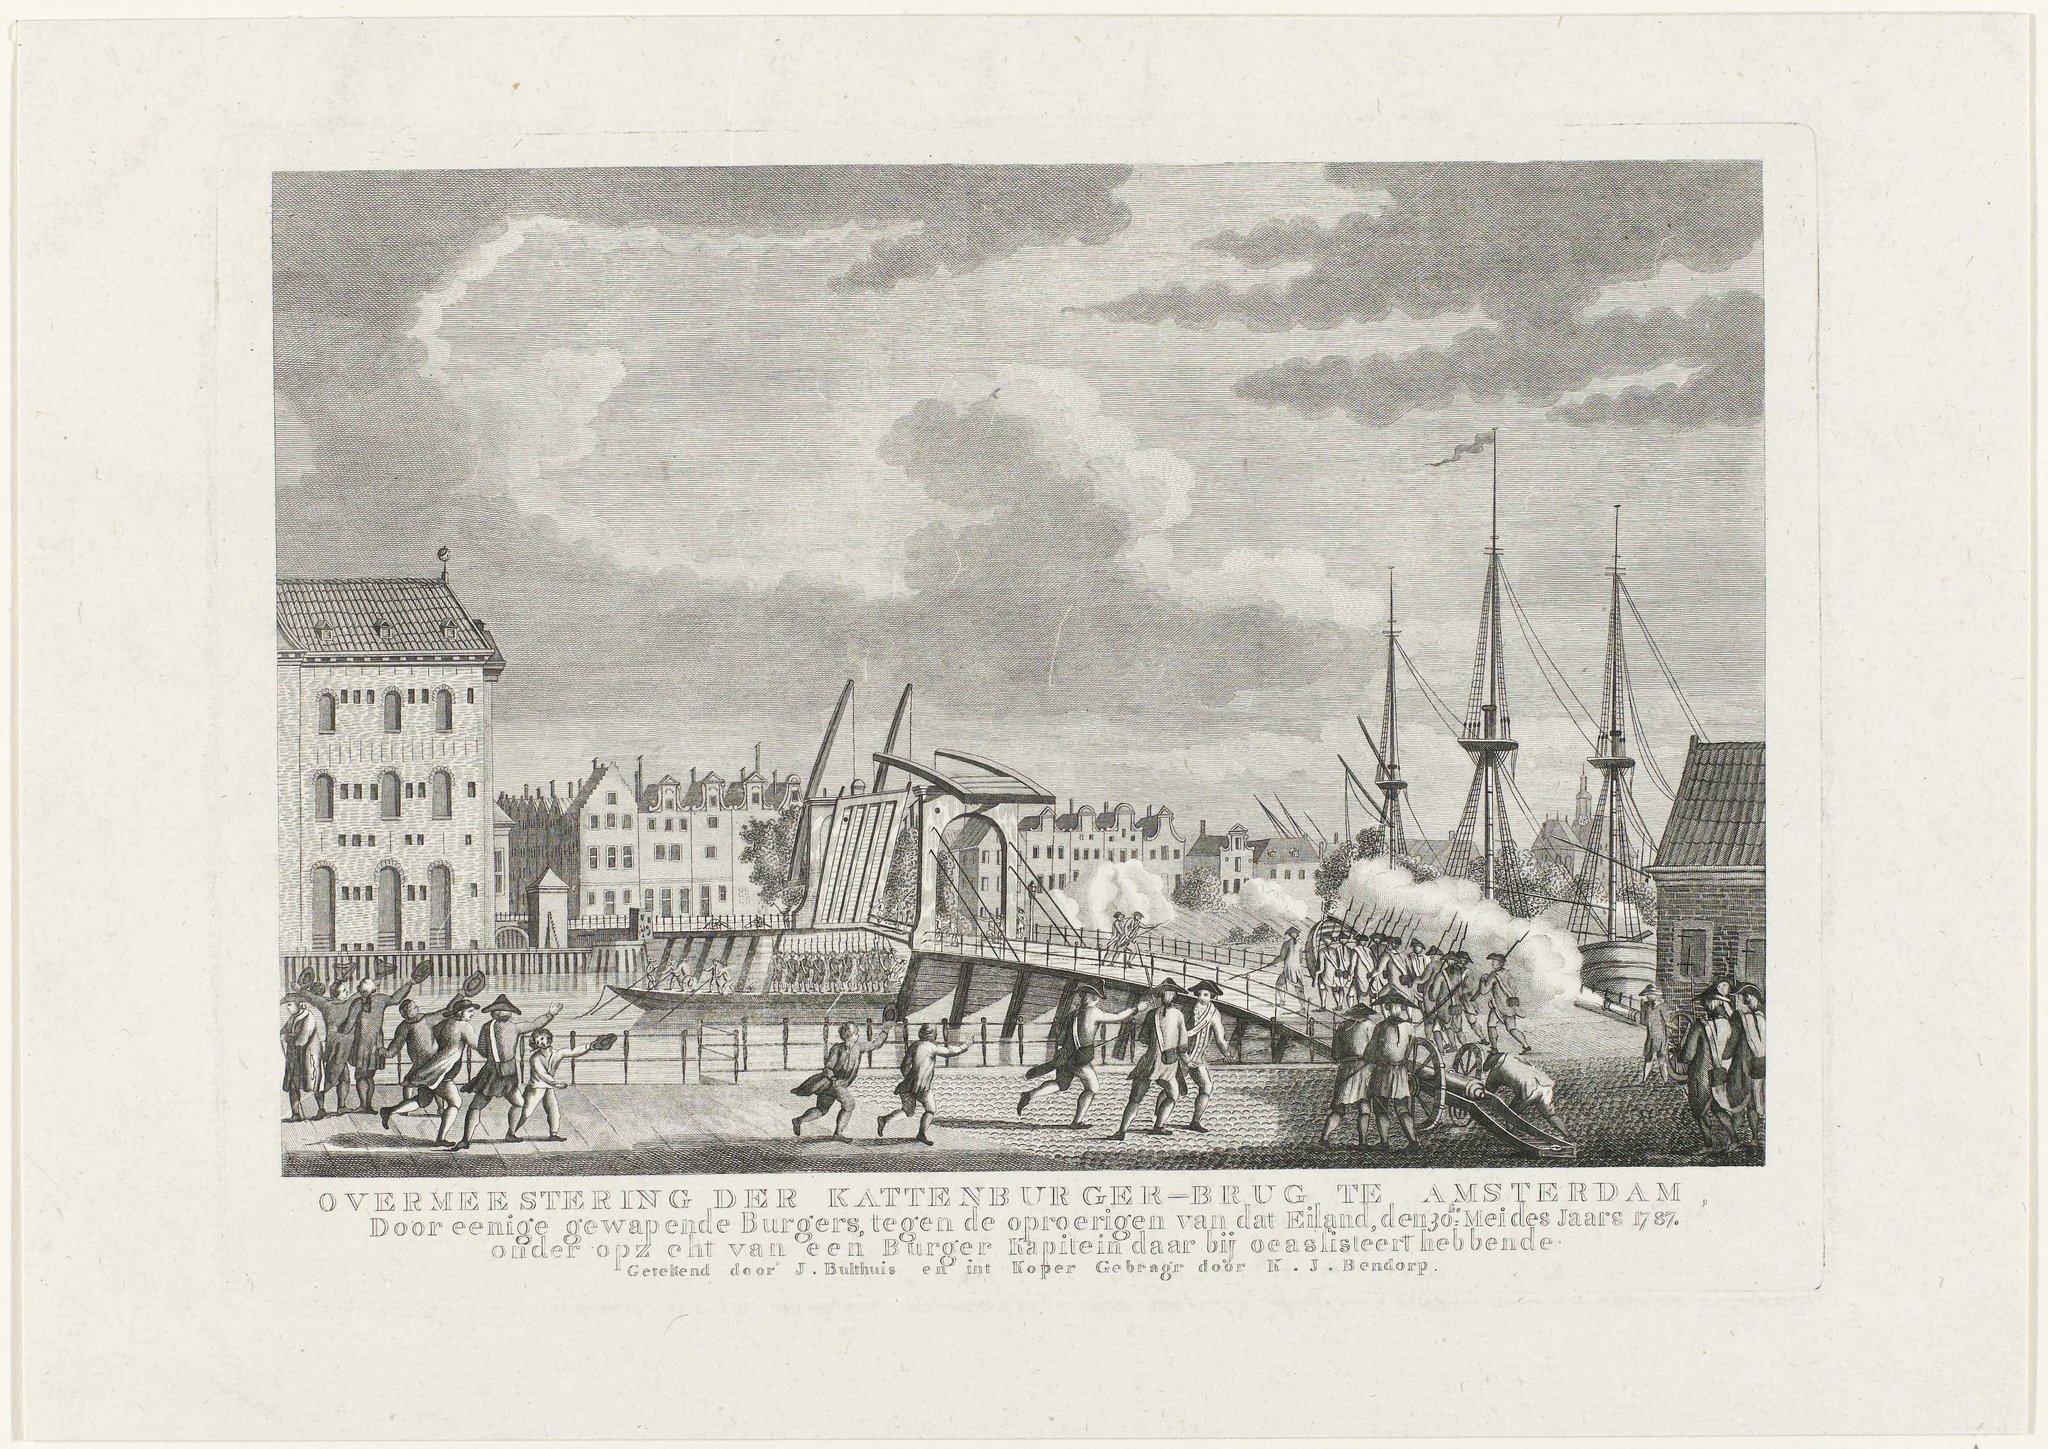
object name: print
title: Verovering van de Kattenburgerbrug, 1787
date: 1787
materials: paper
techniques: engraving, etching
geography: northern netherlands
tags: battle (+ citizen soldiery, civil guard, citizen militia)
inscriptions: collector's mark: Lugt 2228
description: De verovering van de Kattenburgerbrug naar het eiland Kattenburg op de opstandige Oranjegezinden door de gewapende Amsterdamse burgers, 30 mei 1787. Links een deel van 's Lands Zeemagazijn.